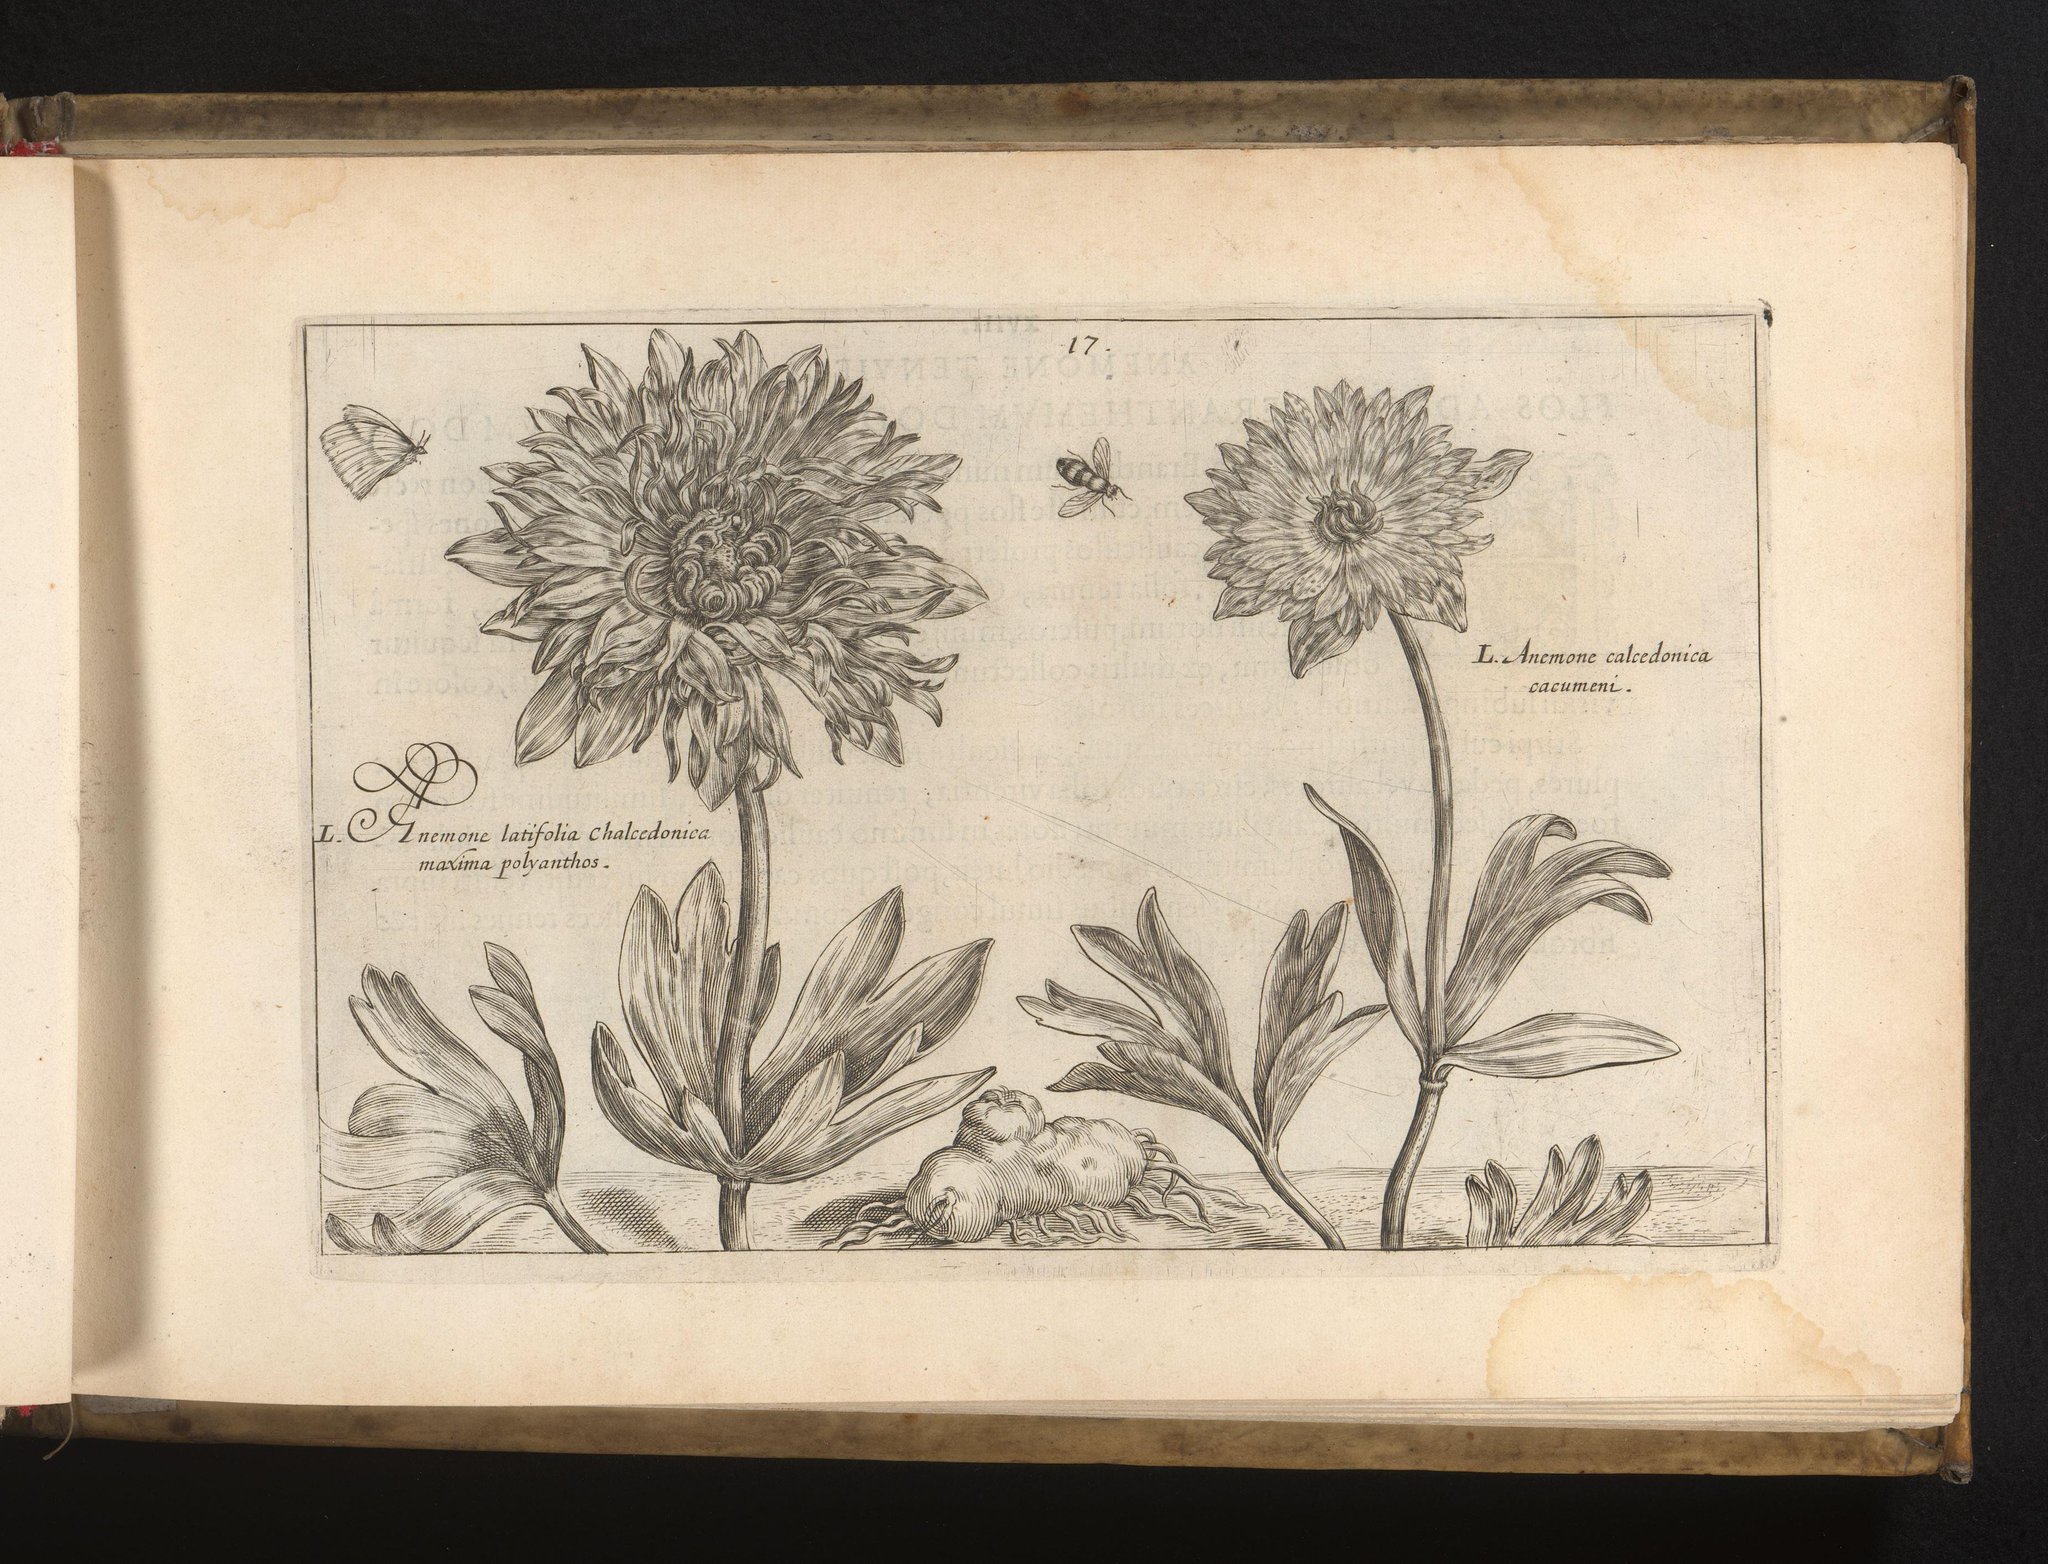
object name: book illustration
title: Bloementuin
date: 1617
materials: paper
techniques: engraving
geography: utrecht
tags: flowers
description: Prent uit: Passe, Crispijn van de (II). Hortus floridus in quo rariorum & minus vulgarium florum icones ad vivam veramque formam. Arnhem: Johannes Janssonius, 1617.